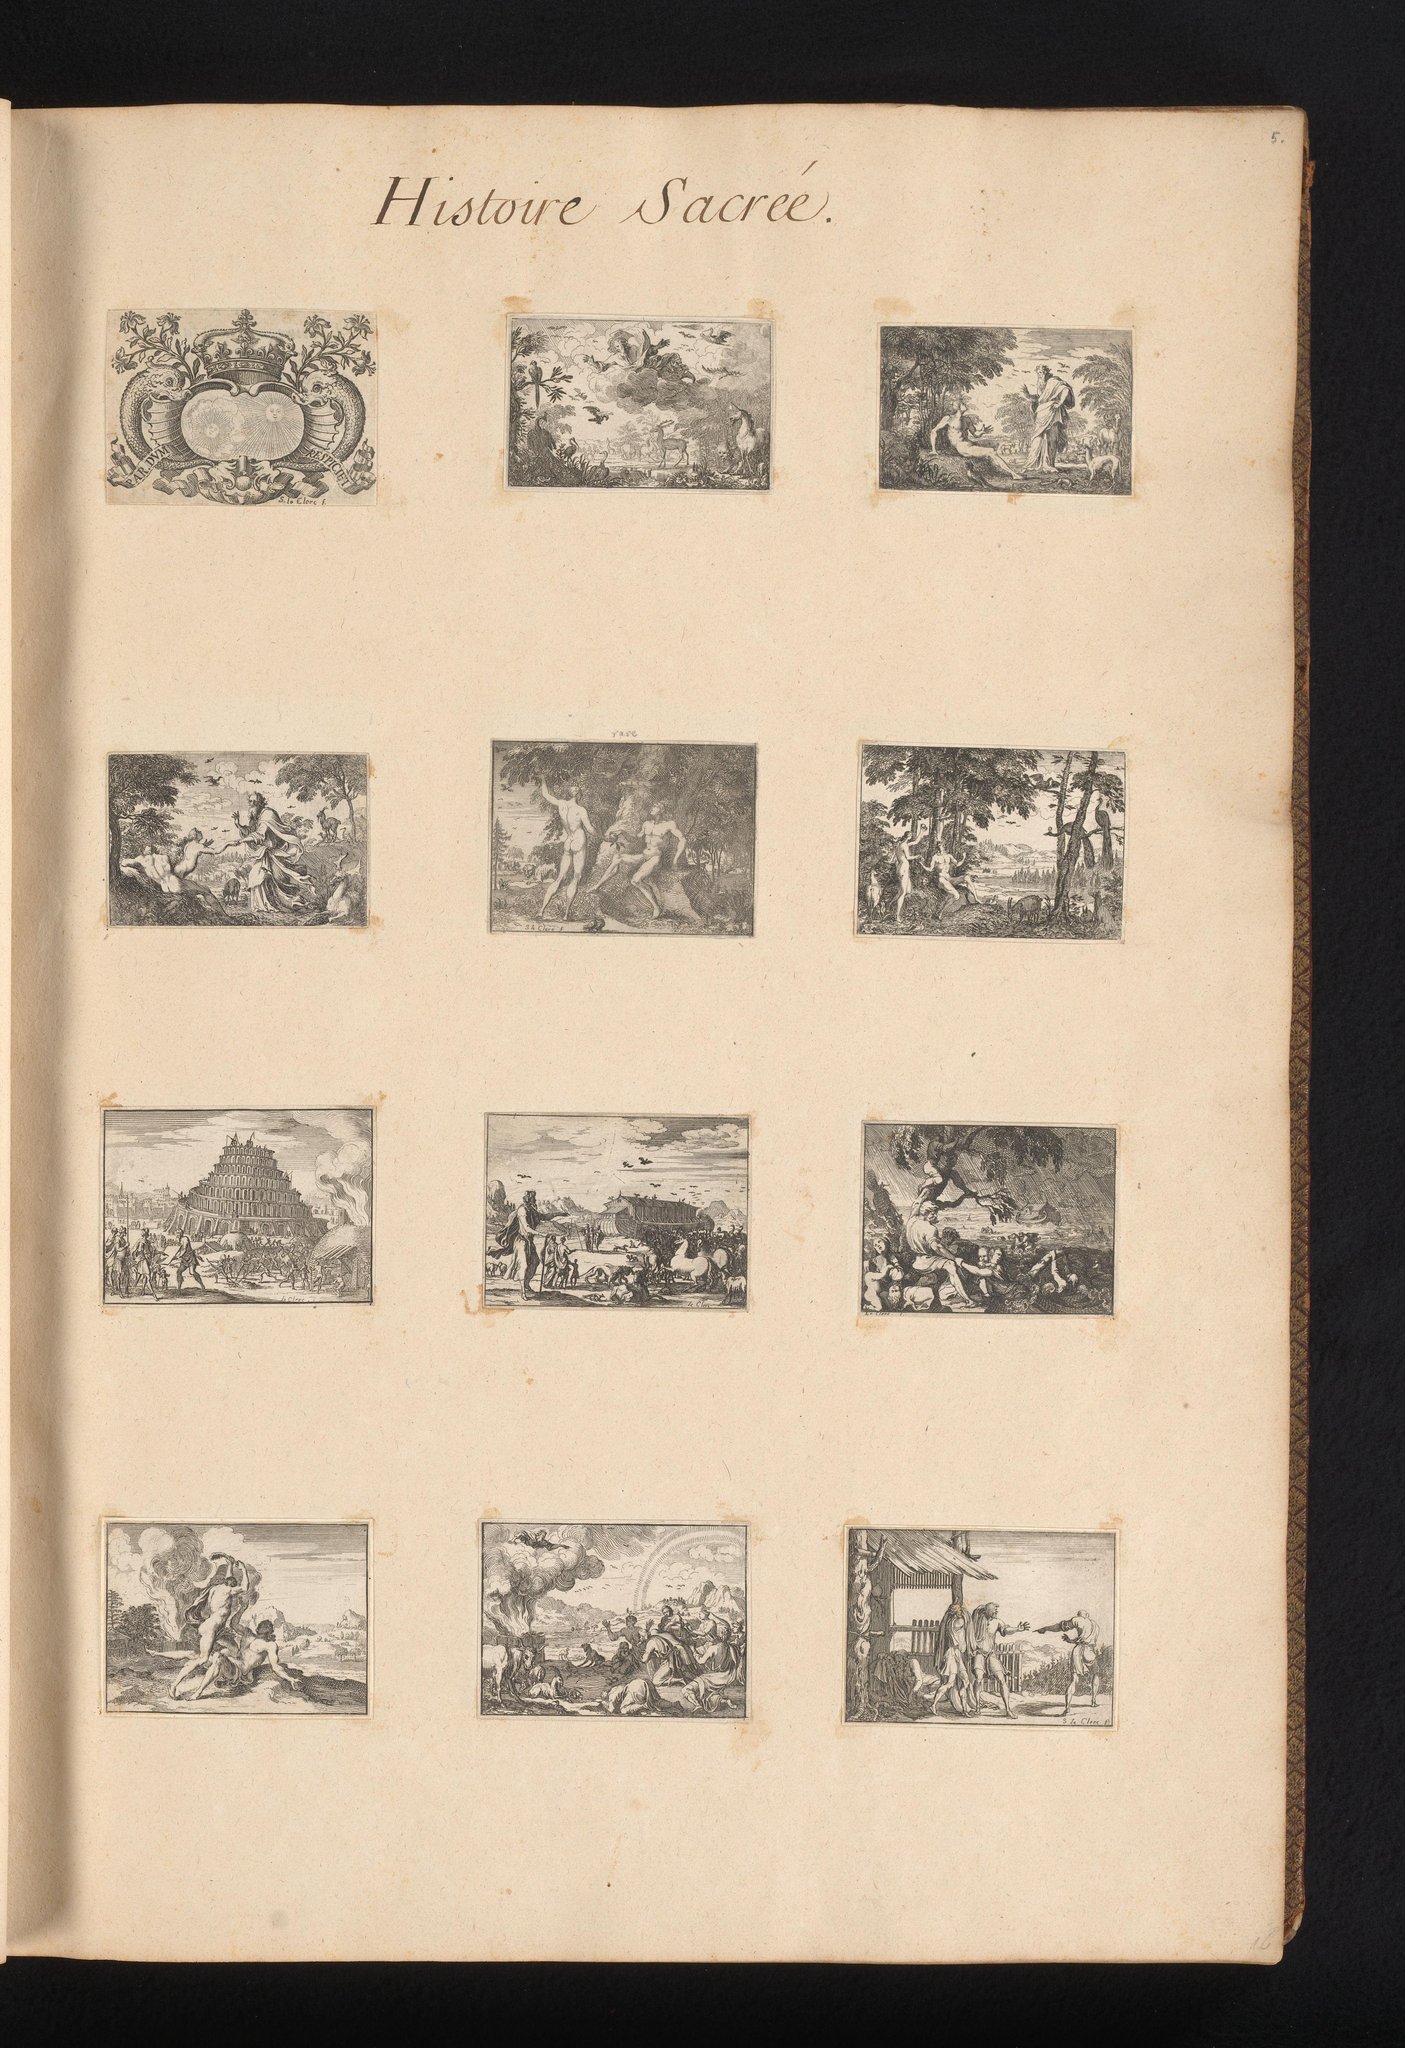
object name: book illustration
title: Titelpagina en elf prenten voor: Finé de Brianville, Histoire sacrée en tableaux (...), 1670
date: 1670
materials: ink, paper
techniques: etching, pen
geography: paris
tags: genesis from the creation to the expulsion from paradise, and later years of adam and eve, genesis from the descendants of cain and seth to abraham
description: Prenten gebruikt voor het eerste deel van: Brianville, Finé de. Histoire sacrée en tableaux (...). Parijs: Charles de Sercy, 1670. In dit boek staan verschillende oudtestamentische voorstellingen en figuren van Adam tot Samuël. De titelpagina betreft volgens IFF 17e siècle niet de titelpagina van het eerste, maar van het tweede deel van de Histoire sacrée en tableaux (...).